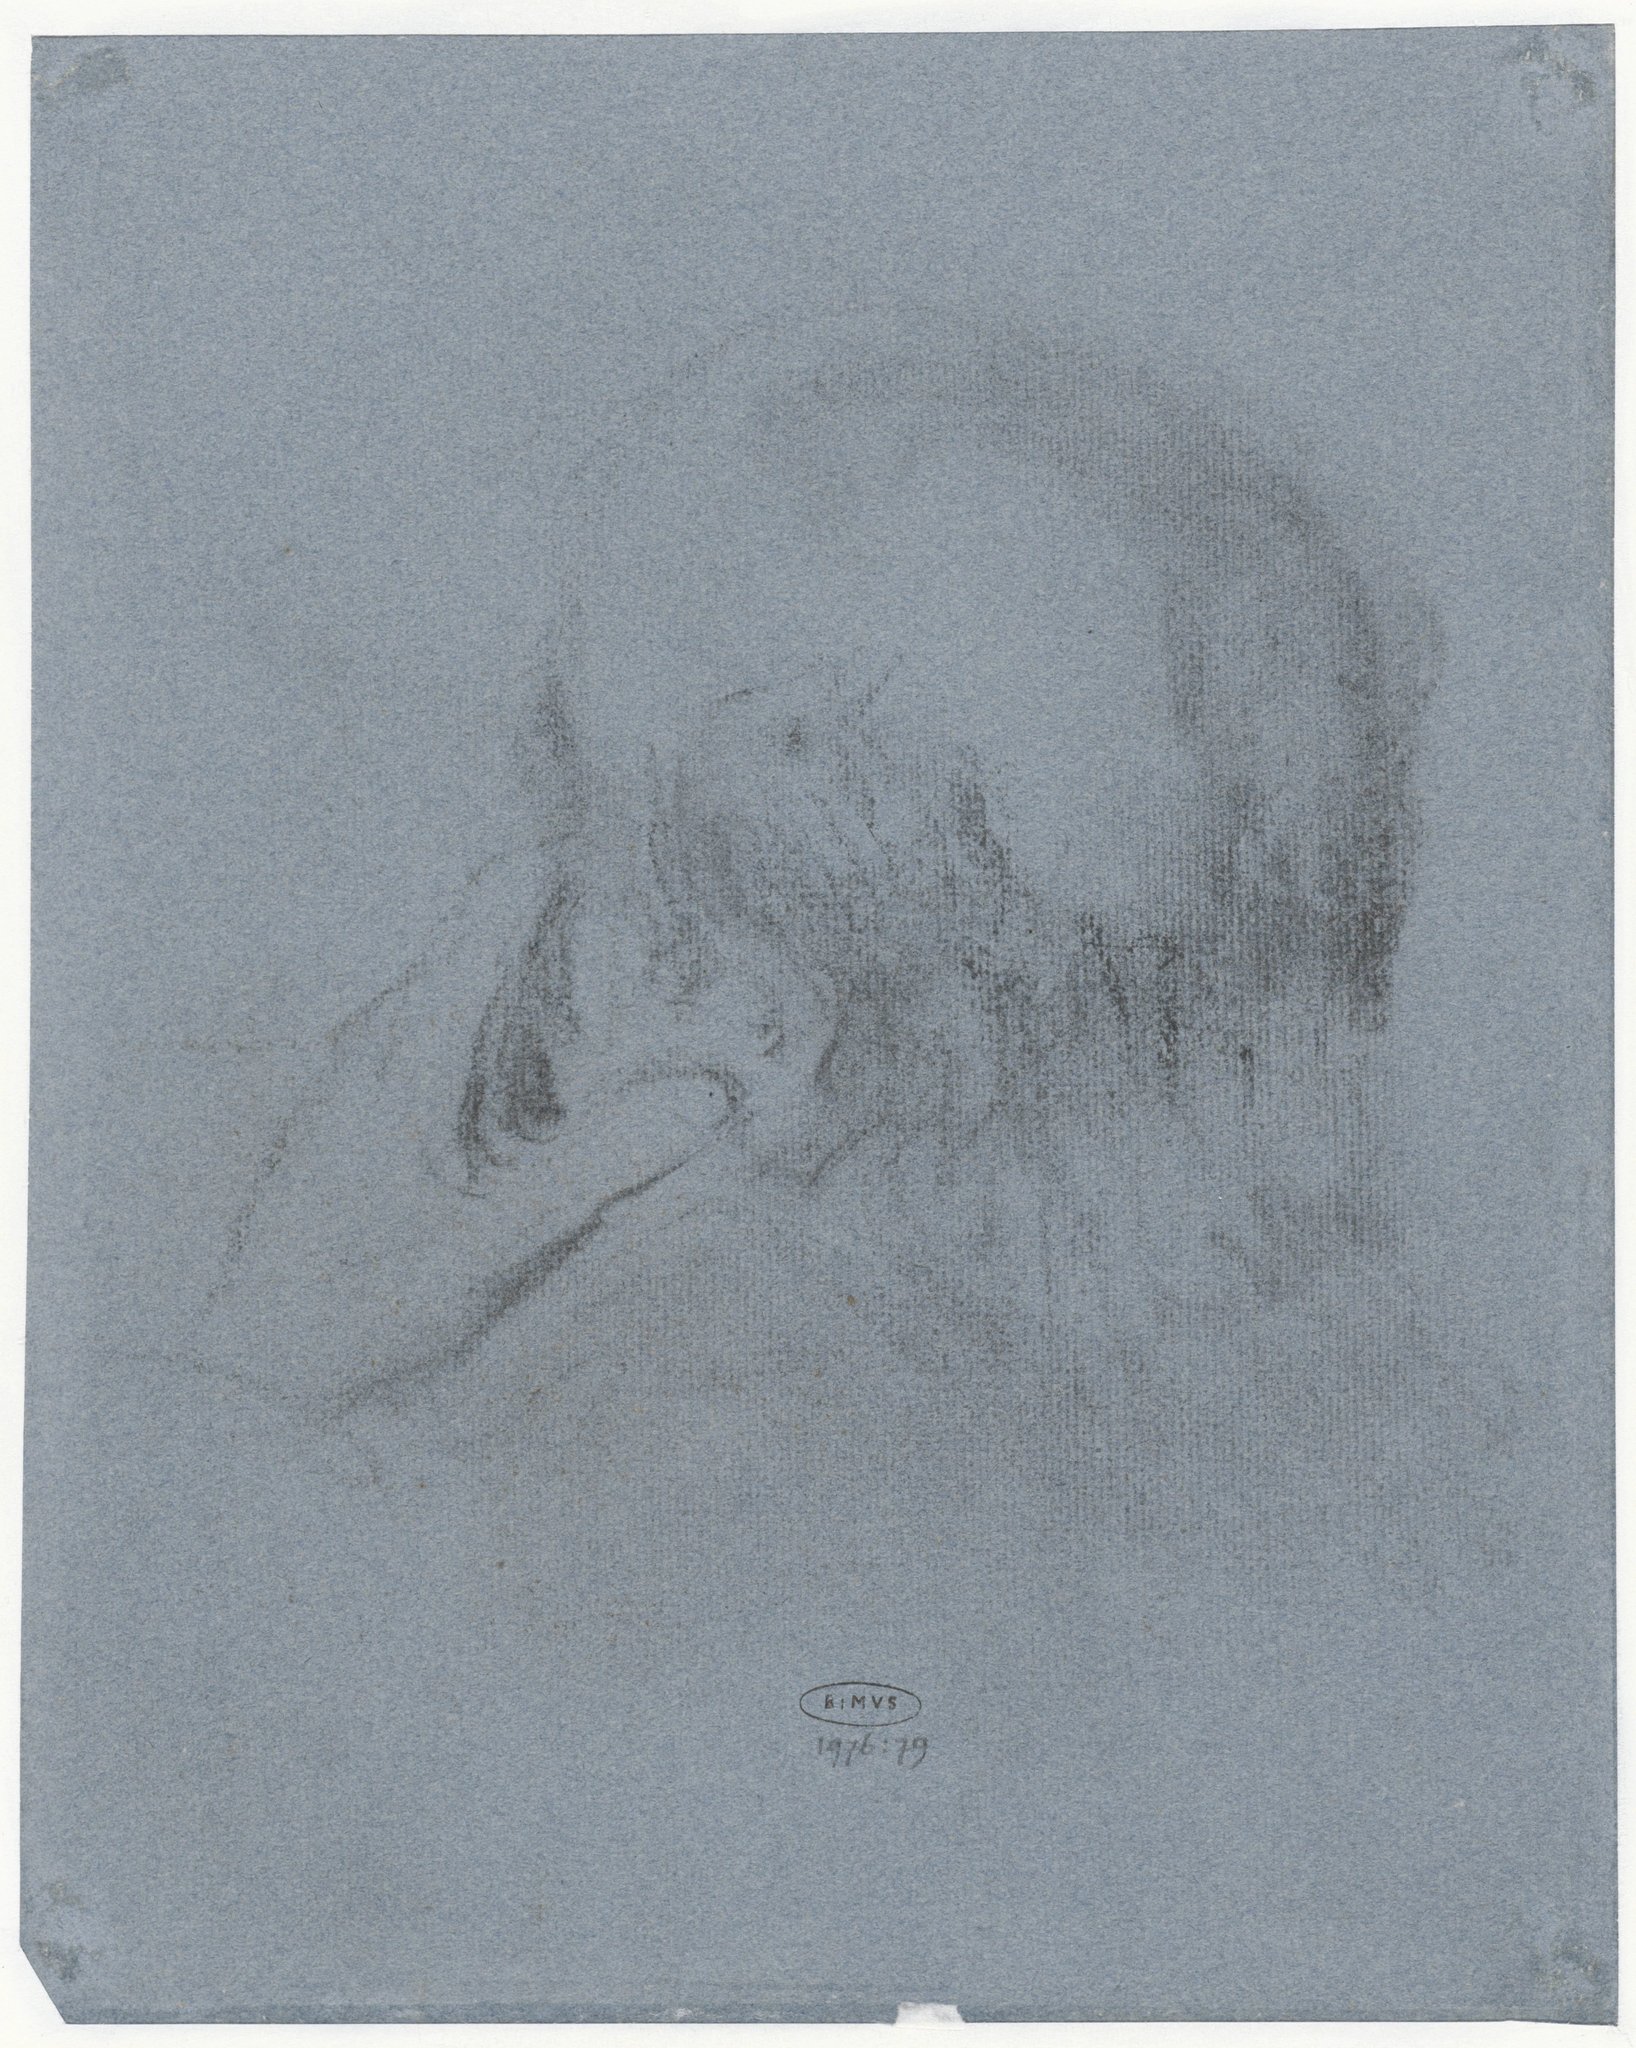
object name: drawing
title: Portretschets van Alphons Marie Antoine Joseph Grandmont, schuin van achteren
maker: a.a.l. de grammont-hubrecht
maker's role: draughtsman, painter, print maker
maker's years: 1855-1913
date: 1865-1913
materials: chalk, paper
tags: historical persons